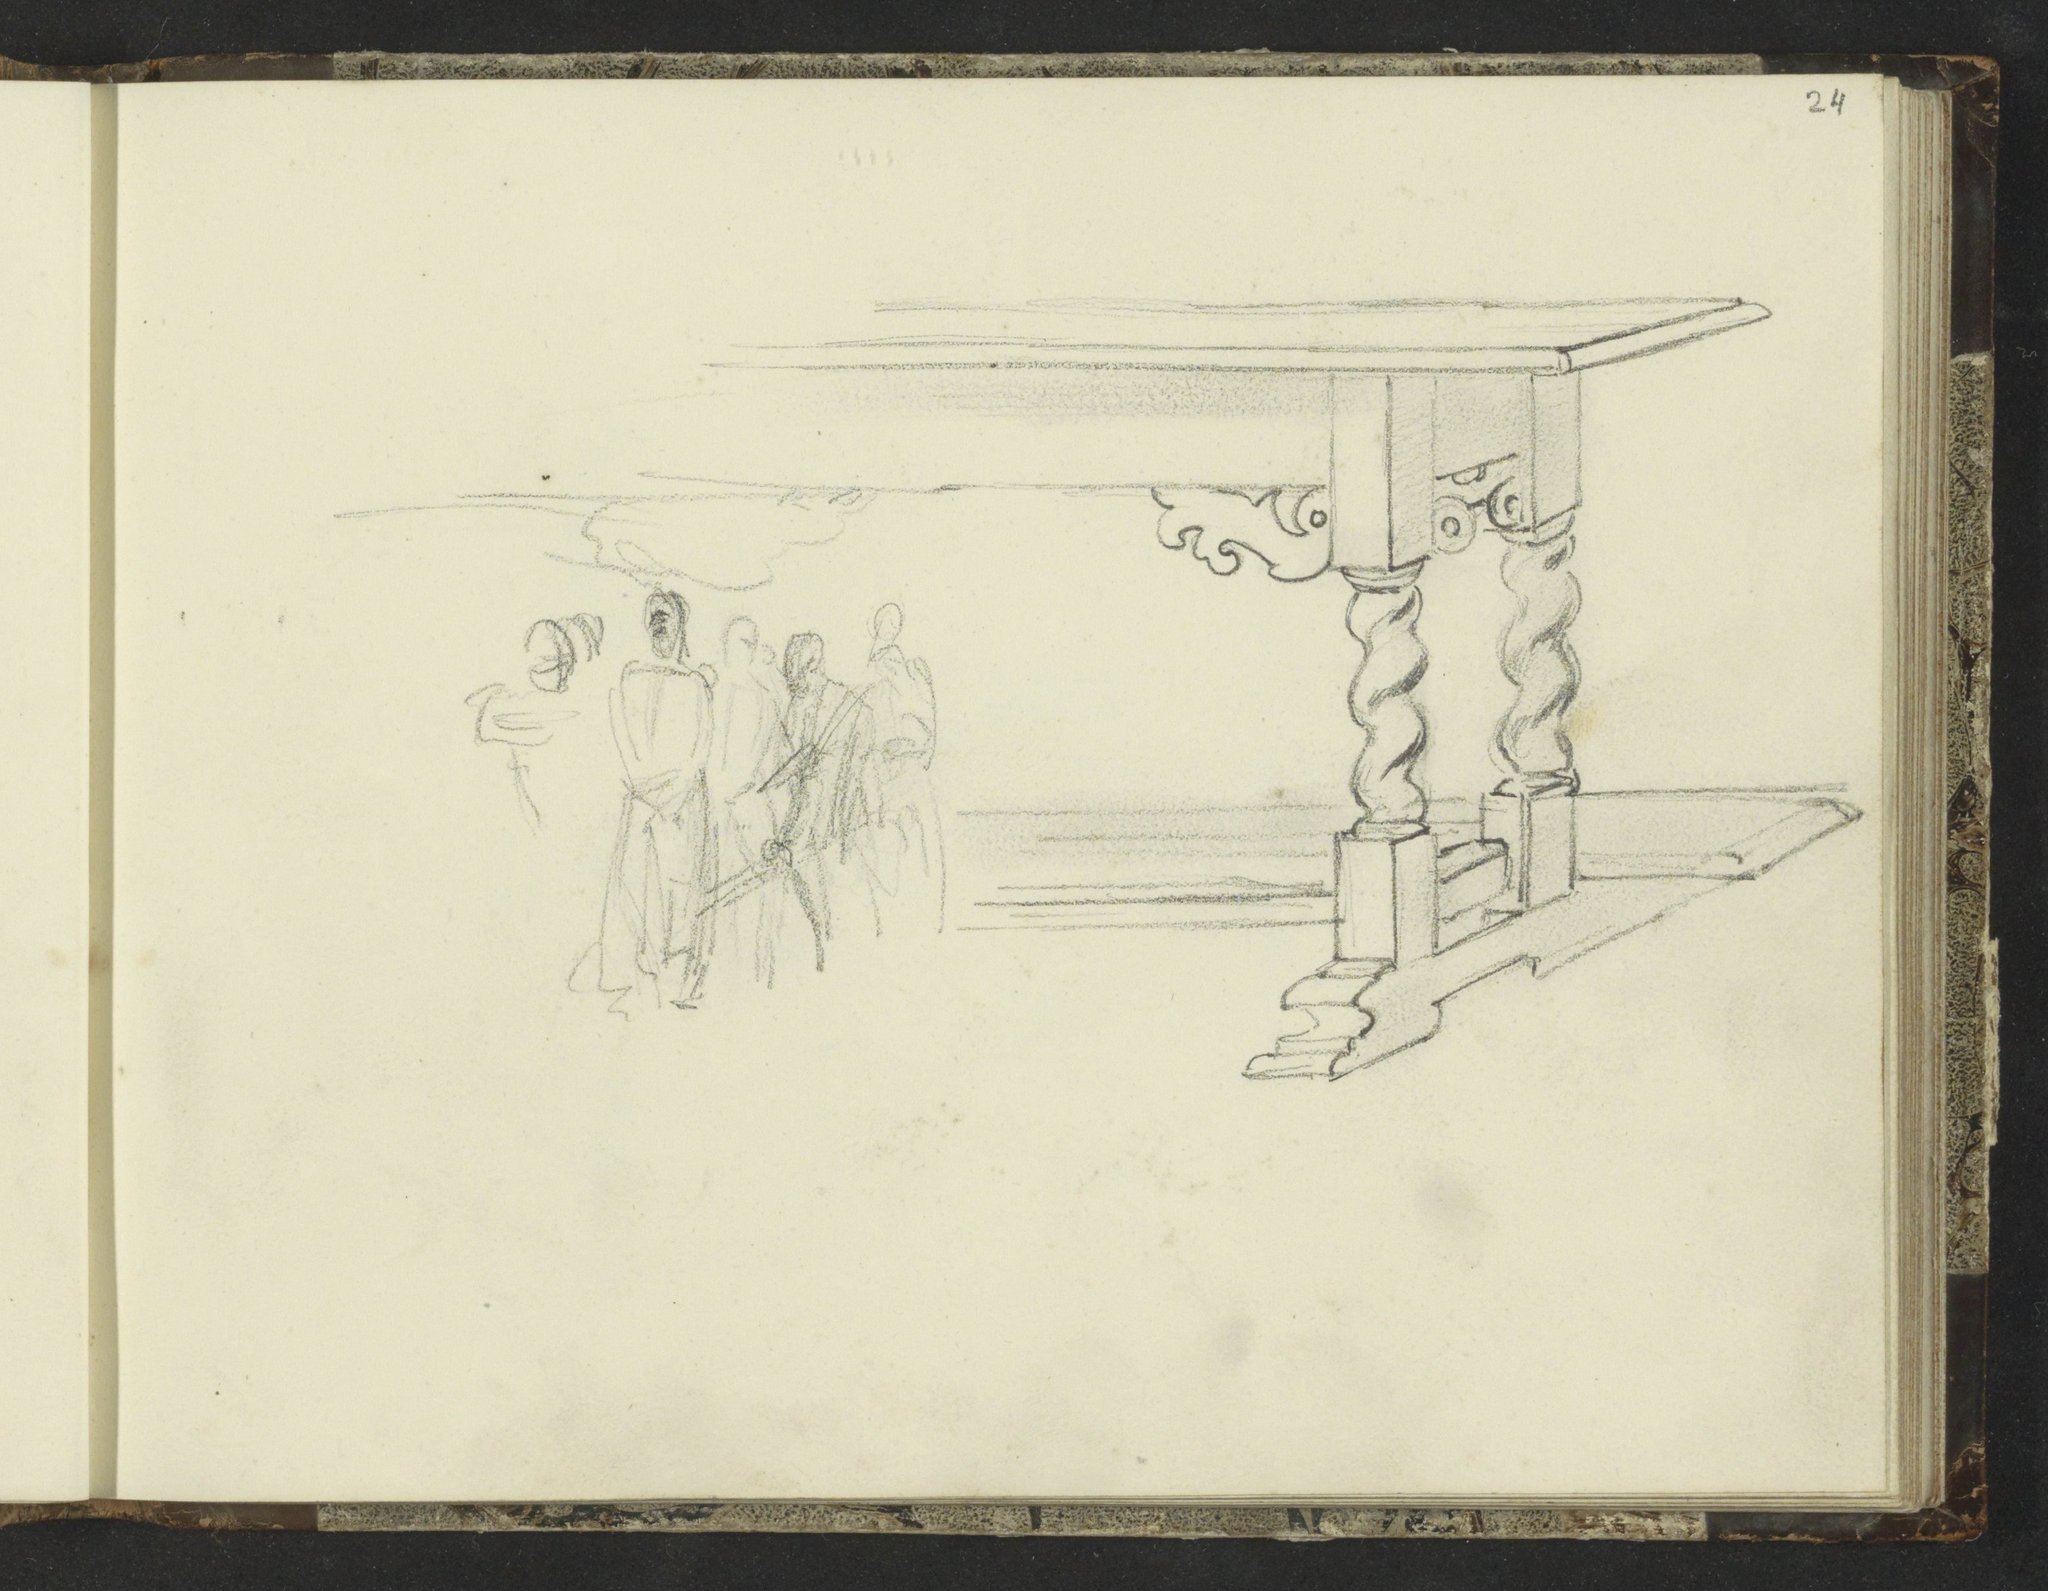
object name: sketchbook leaf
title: Tafel en een groep staande figuren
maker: willem hendrik schmidt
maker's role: draughtsman, painter, print maker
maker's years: 1809-1849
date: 1819-1849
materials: paper, pencil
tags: standing figure, table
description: Blad 24 recto uit een schetsboek met 58 bladen.